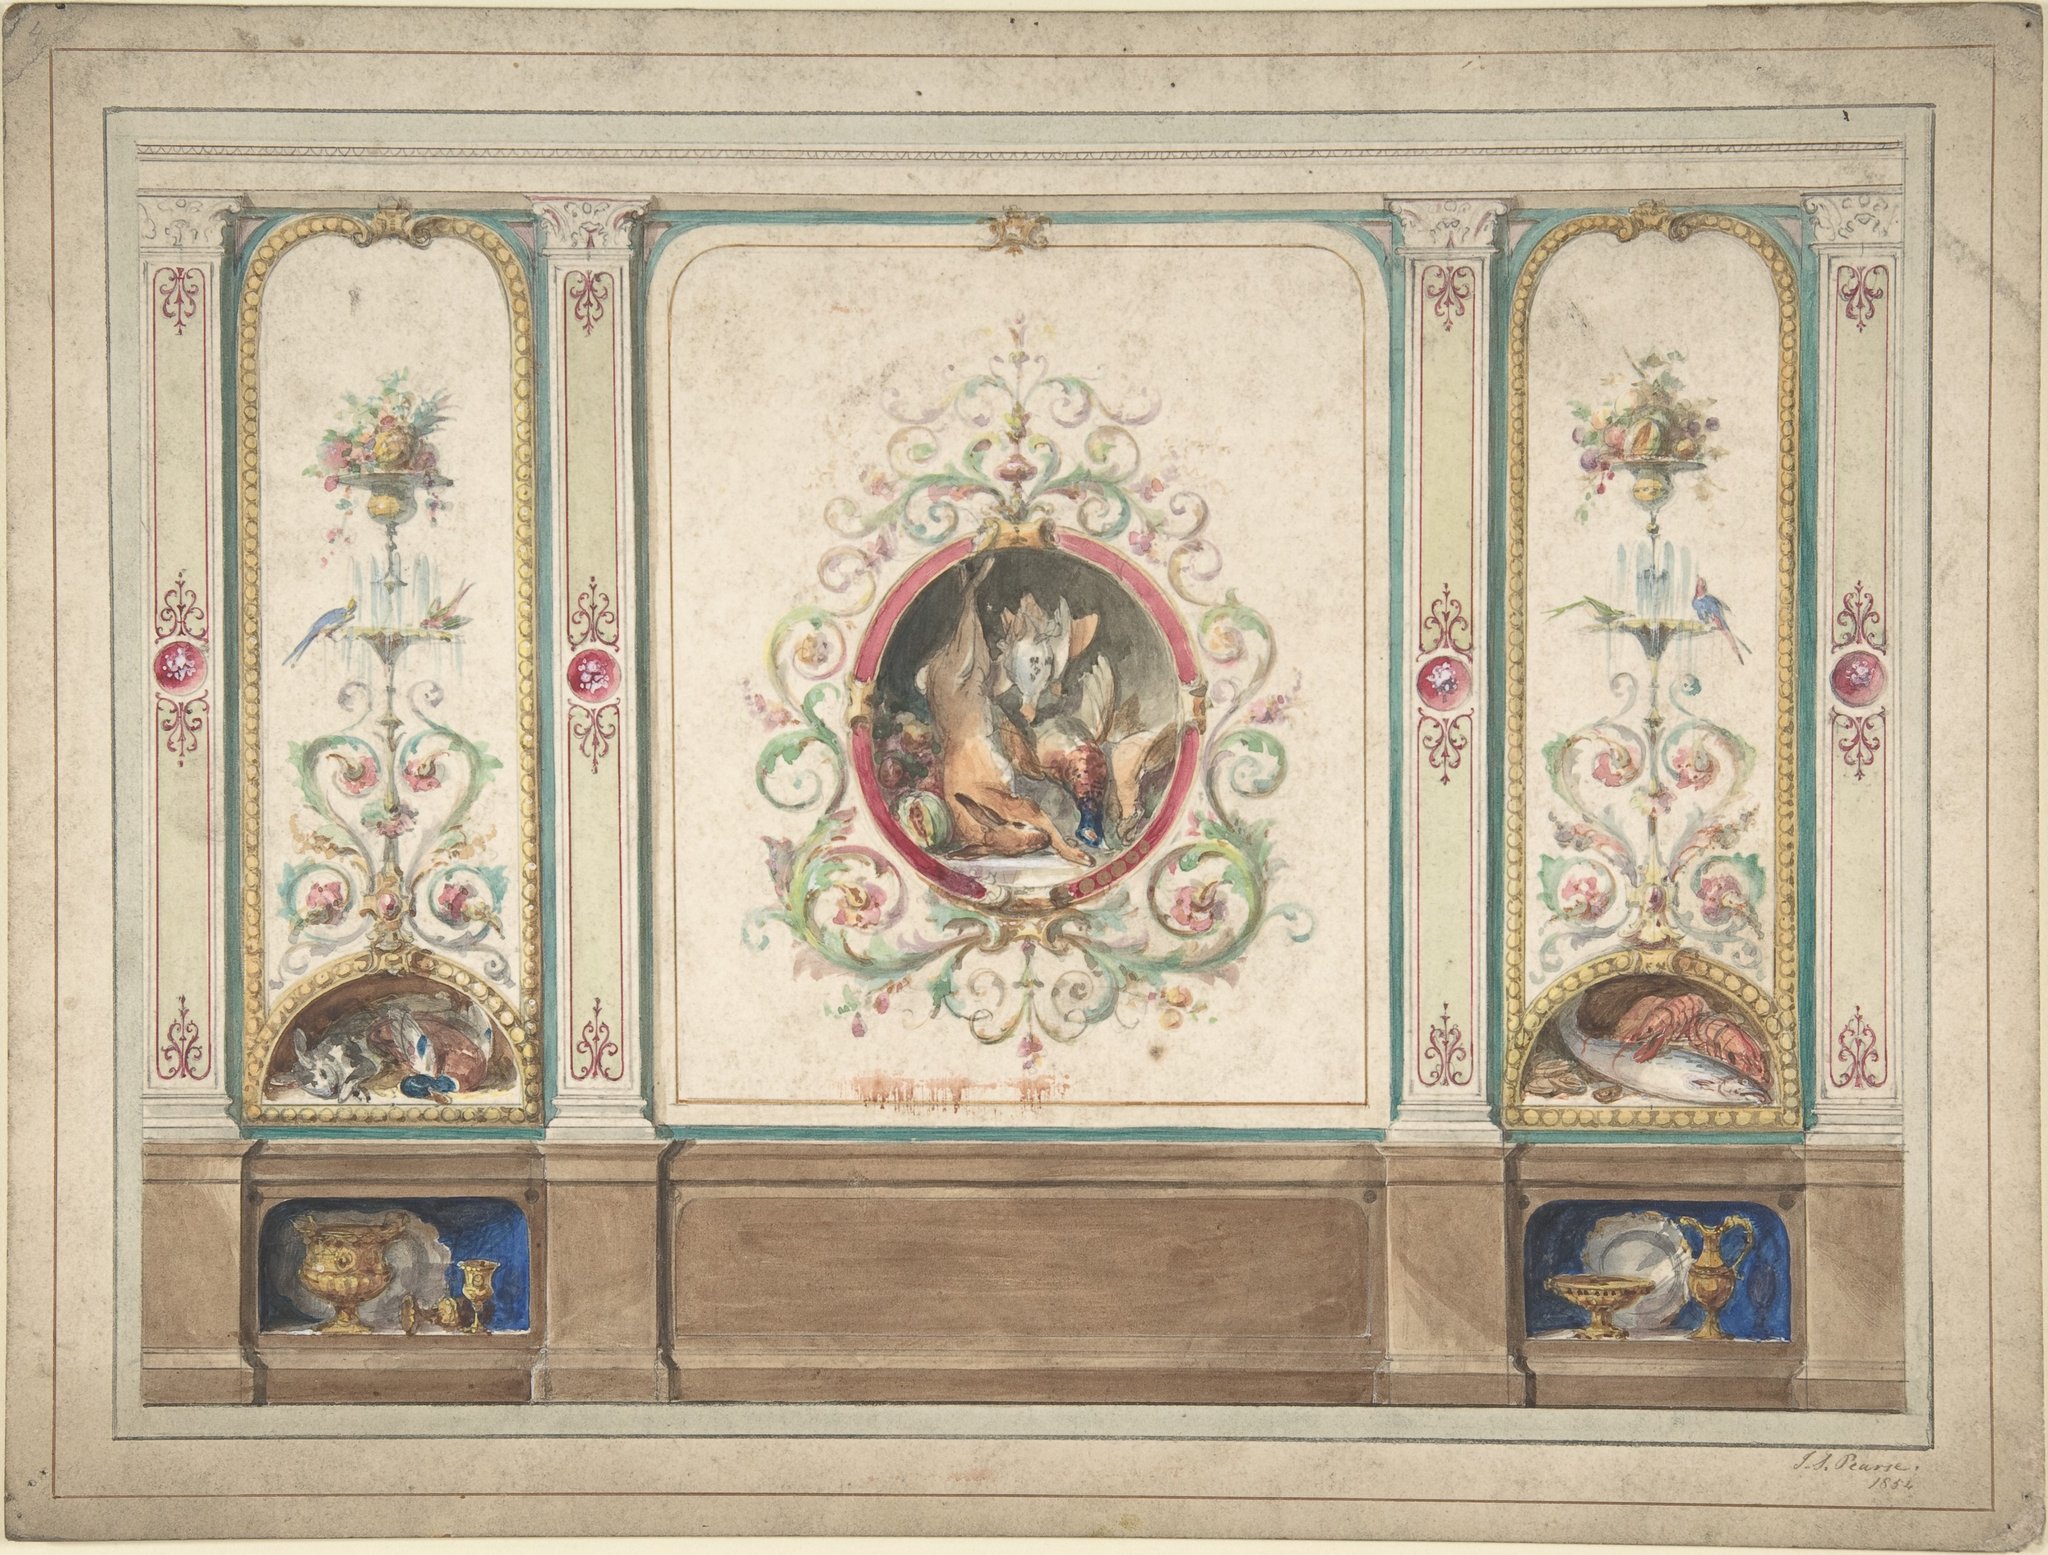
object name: drawing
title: Design for Decorative Panels with Hunting Scenes Inset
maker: j. s. pearse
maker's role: artist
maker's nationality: british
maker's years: 1800-1900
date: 1854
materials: watercolor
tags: animals,hunting